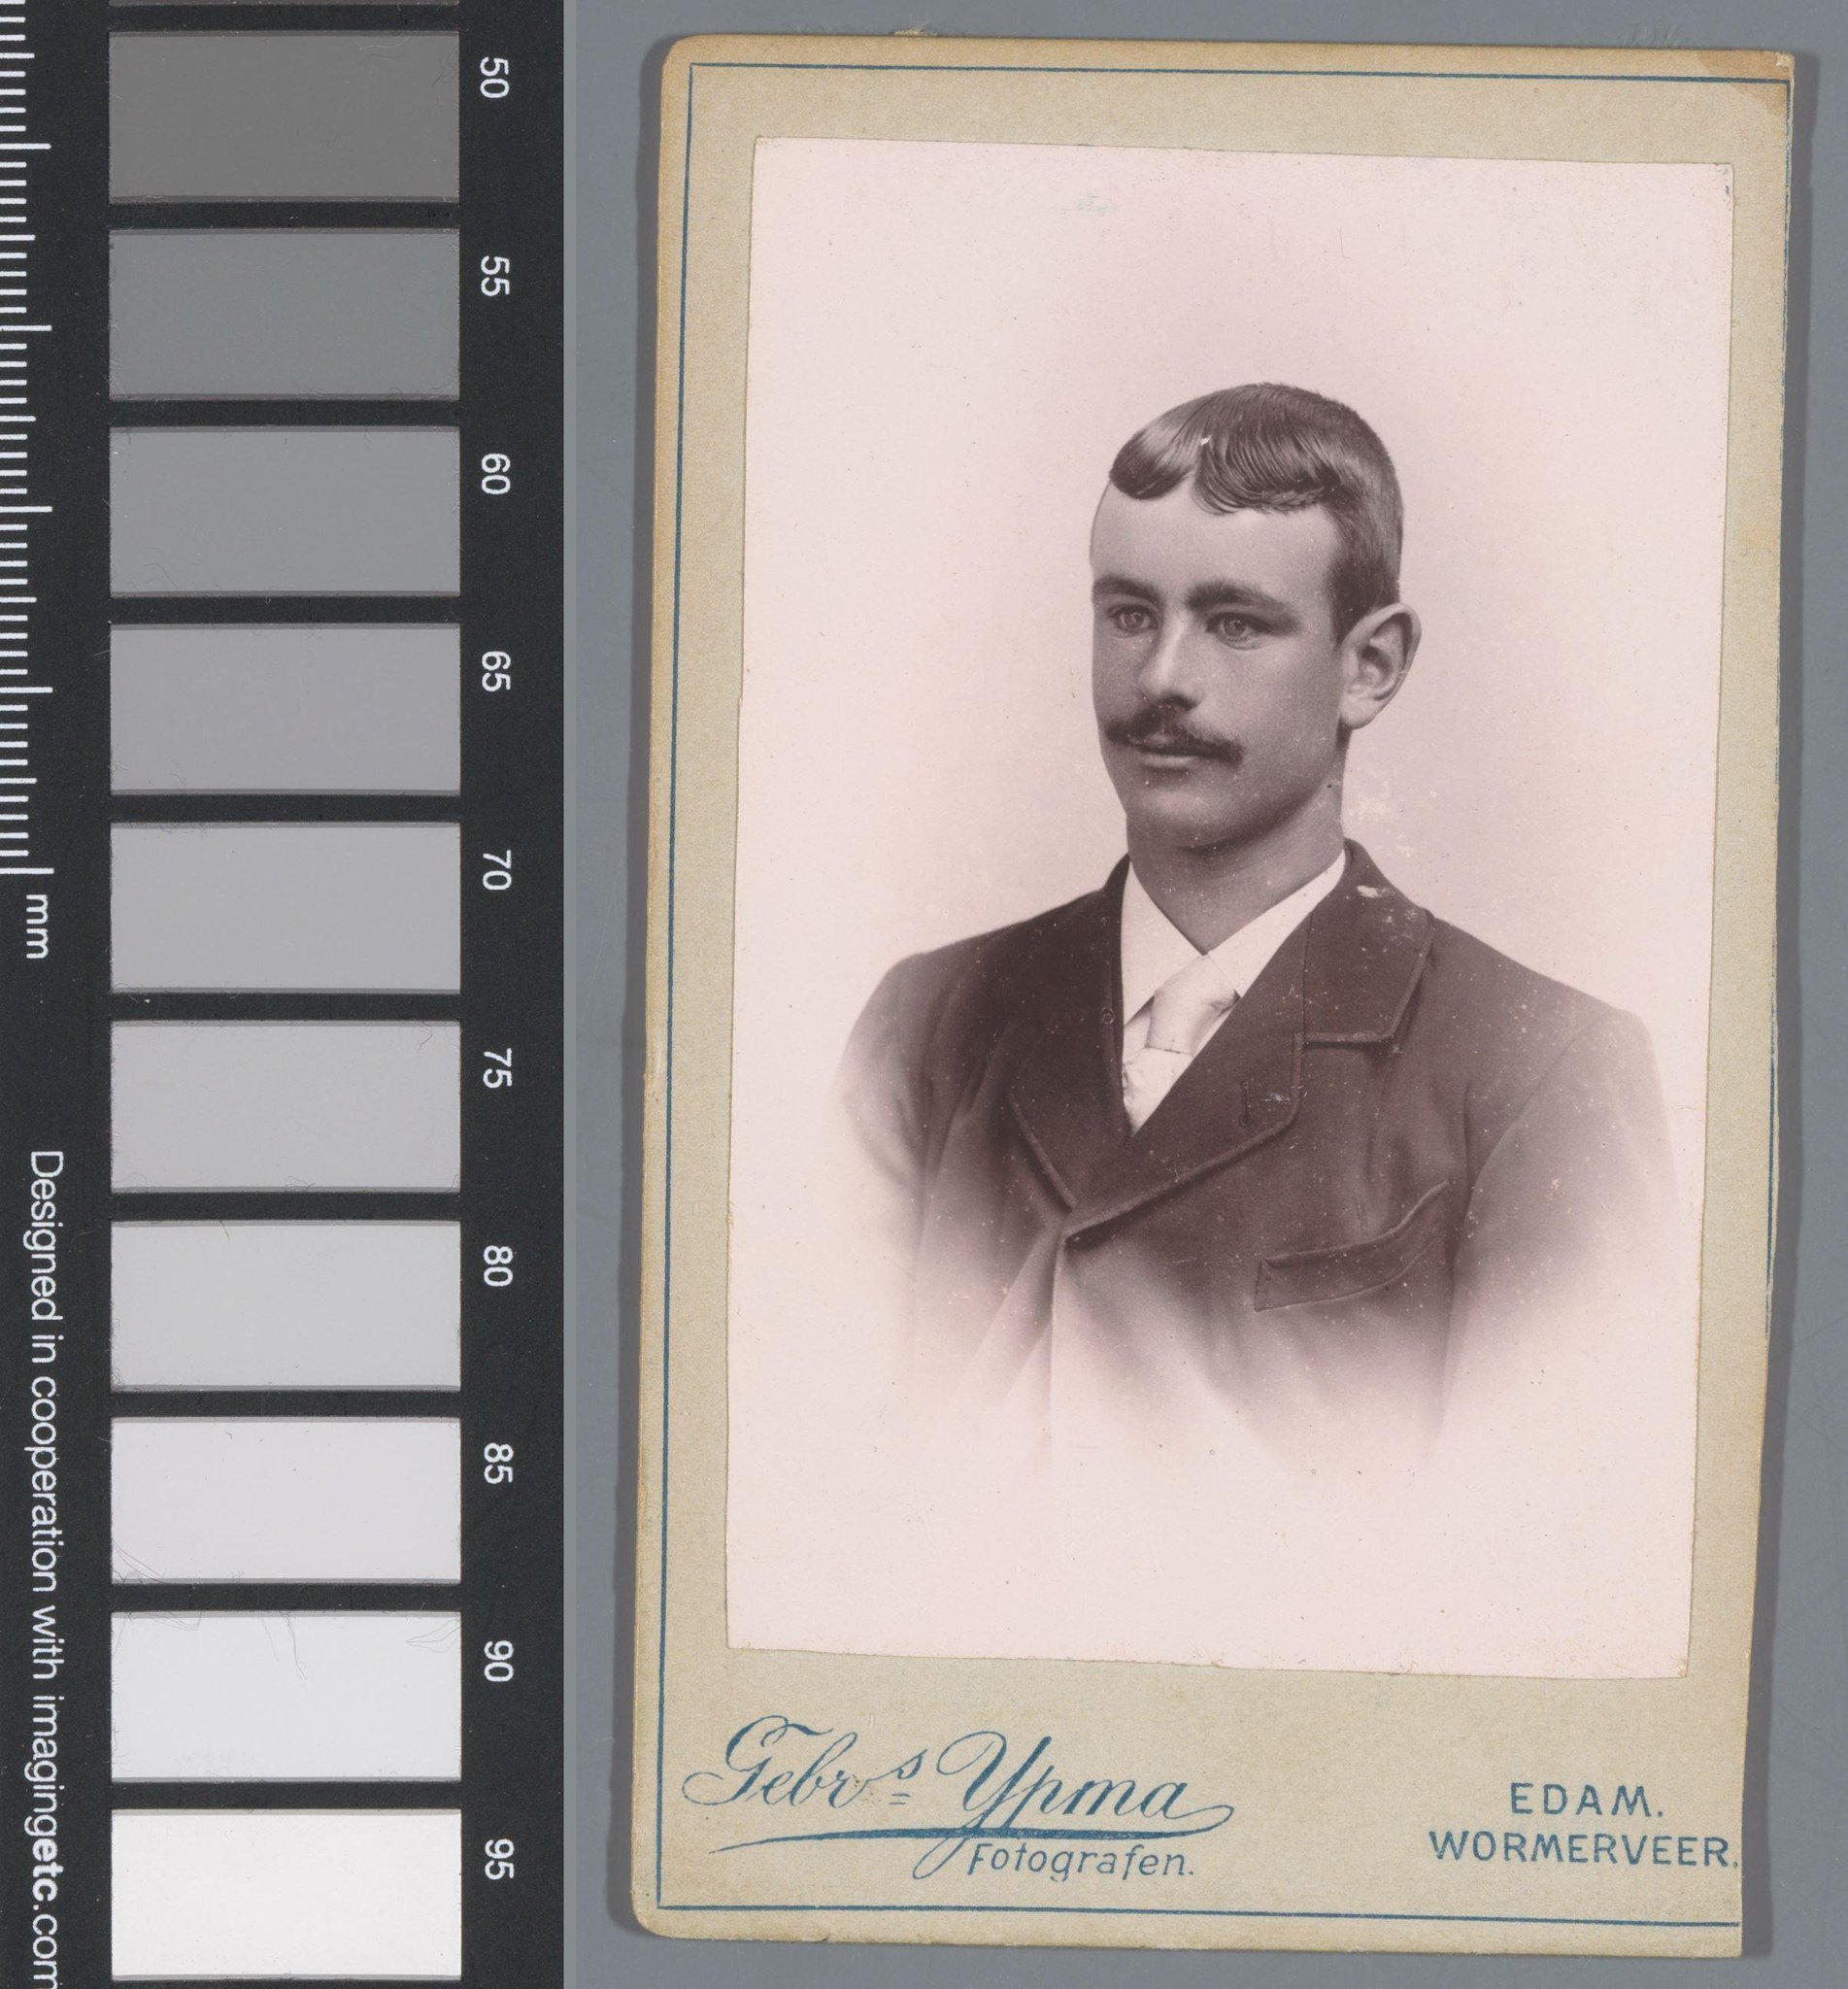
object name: carte de visite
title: Portret van Cornelis bij 't Vuur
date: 1894-1898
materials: cardboard, photographic support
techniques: collodion silver print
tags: adult man, historical persons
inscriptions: inscription: ‘Corn. bij 't Vuur’, inscription: ‘ATELIERS/ voor/ ONVERANDERLIJKE/ PORTRETTEN/ Gebroeders IJpma/ EDAM/ WORMERVEER/ Wandelweg./ Speciale inrichting voor vergrootingen./ Het cliché blijft voor nabestelling bewaard.’